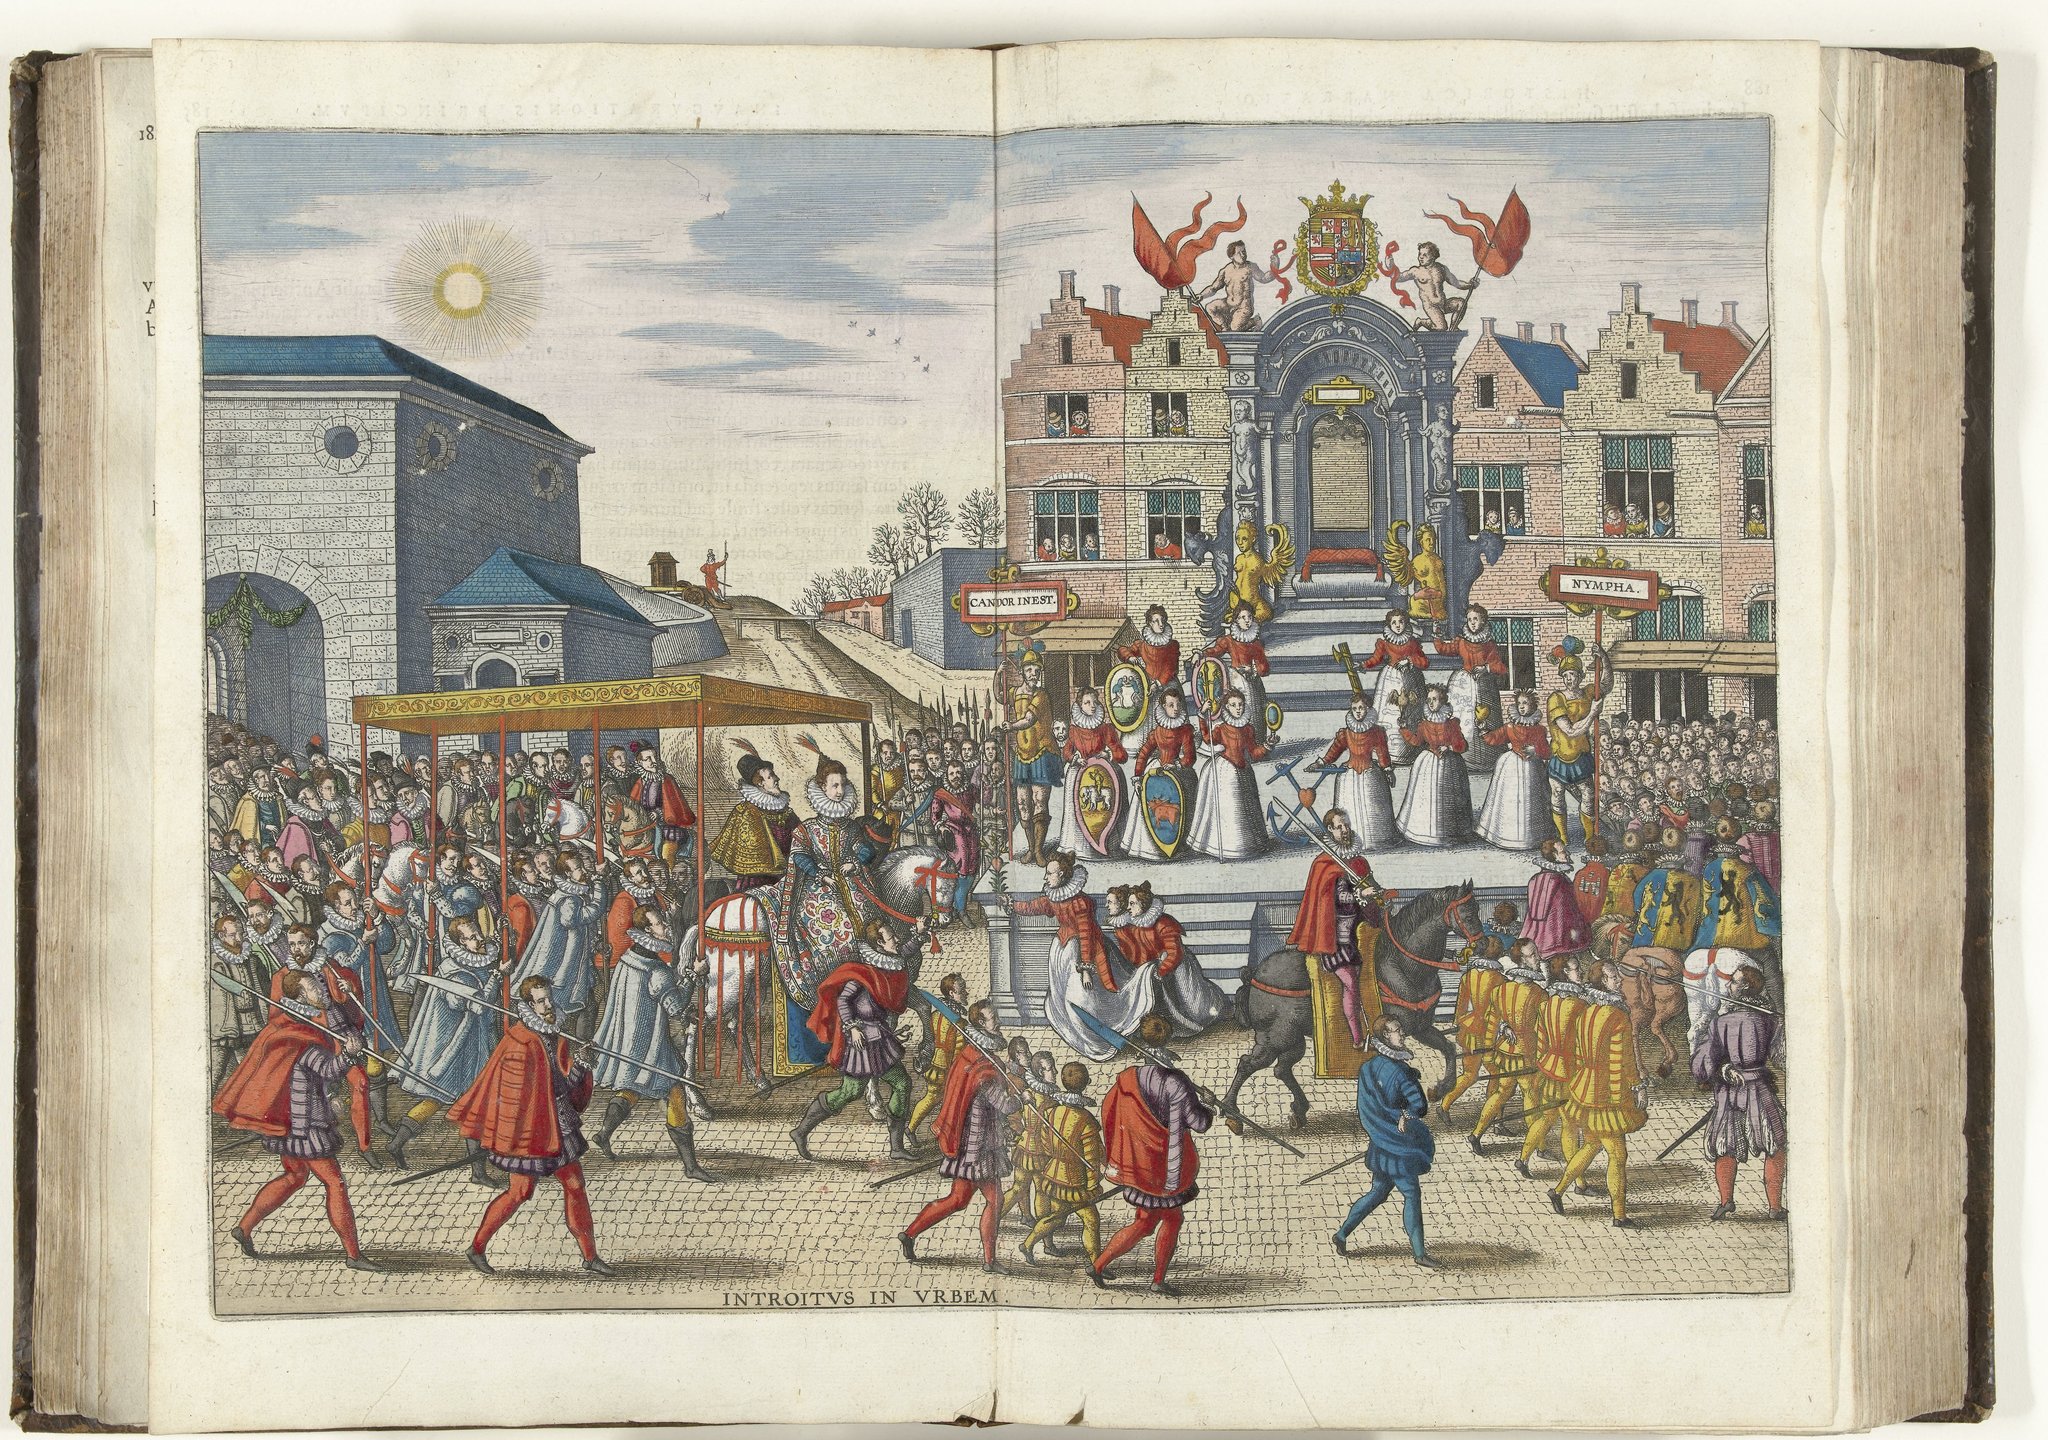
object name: print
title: Welkomst in de stad, 1599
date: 1599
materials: paper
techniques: etching, hand coloring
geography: southern netherlands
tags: infante van spanje isabella clara eugenia, albrecht aartshertog van oostenrijk, 'tableau vivant', triumphal entry and public reception, pageant, 'entrée solennelle', 'joyeuse entrée', antwerp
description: Welkomst in de stad. Albrecht en Isabella te paard onder een troonhemel worden binnen de stad verwelkomd door de stadsmaagd van Antwerpen bij een toneel met allegorische figuren, december 1599. Tijdens de intocht te Antwerpen. Onderdeel van: Historica narratio profectionis et inaugurationis serenissimorum Belgii principum Alberti et Isabellae Austriae archiducum, de beschrijving van de intochten van het paar te Brussel, Antwerpen, Gent en Valenciennes, 1599.